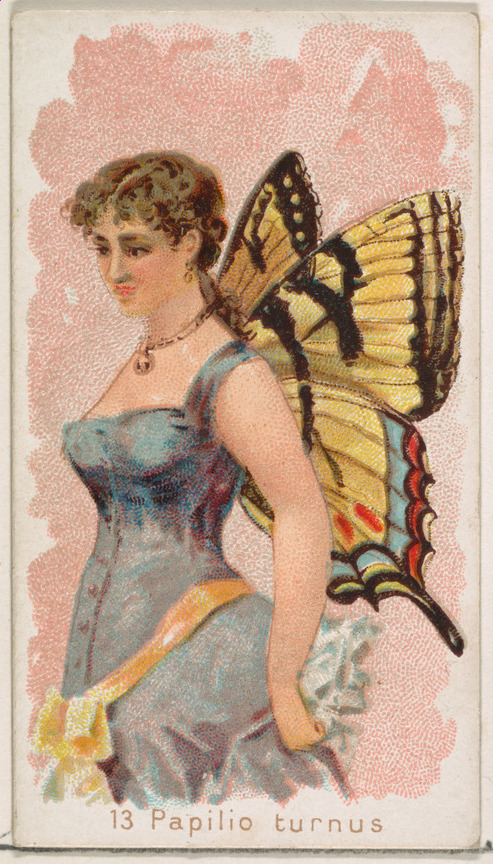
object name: print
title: Card 13, Papilio Turnus, from the Butterflies series (N183) issued by Wm. S. Kimball & Co.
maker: william s. kimball & company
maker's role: publisher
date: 1888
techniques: color lithograph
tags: women,butterflies